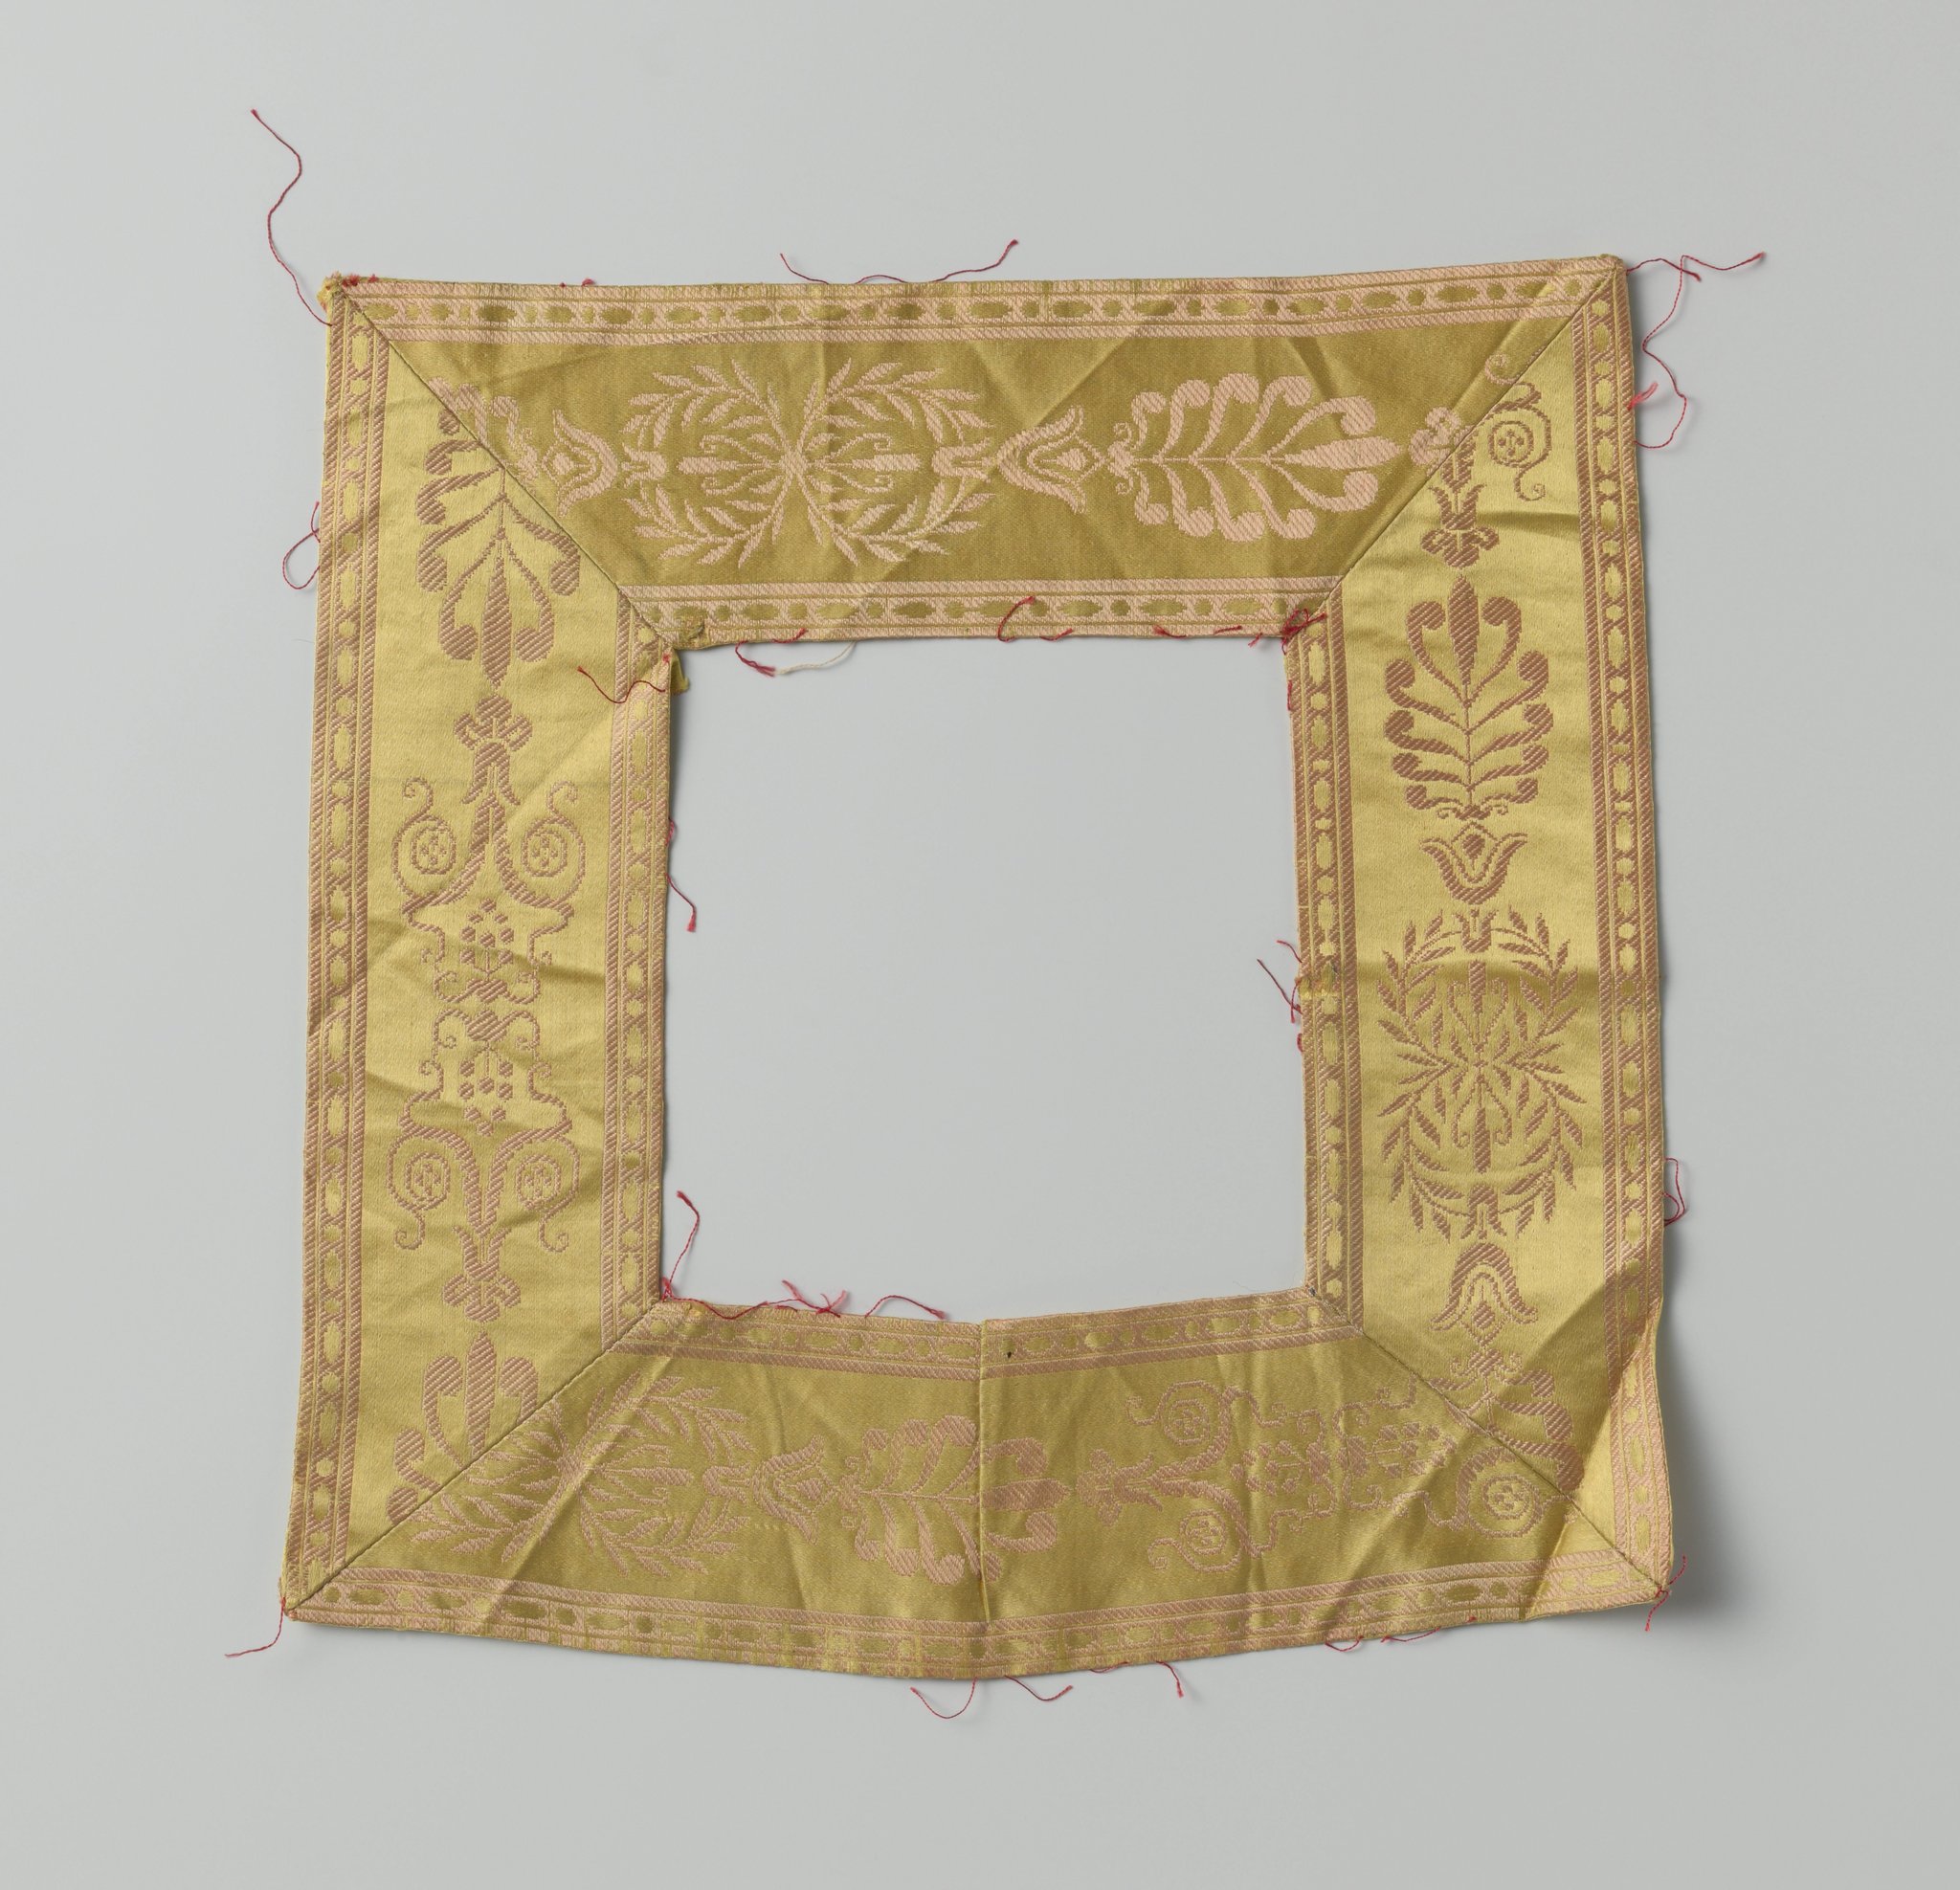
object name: stoelbekleding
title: Fragment zijdeweefsel van een stoelbekleding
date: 1805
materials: silk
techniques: brocade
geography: france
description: Fragment geel zijdeweefsel, van een stoelbekleding. Het patroon heeft op een gele grond roze palmetten en arabesken. Het fragment hoort bij dertien fragmenten met invnr. BK-1992-18-A t/m BK-1992-18-M.